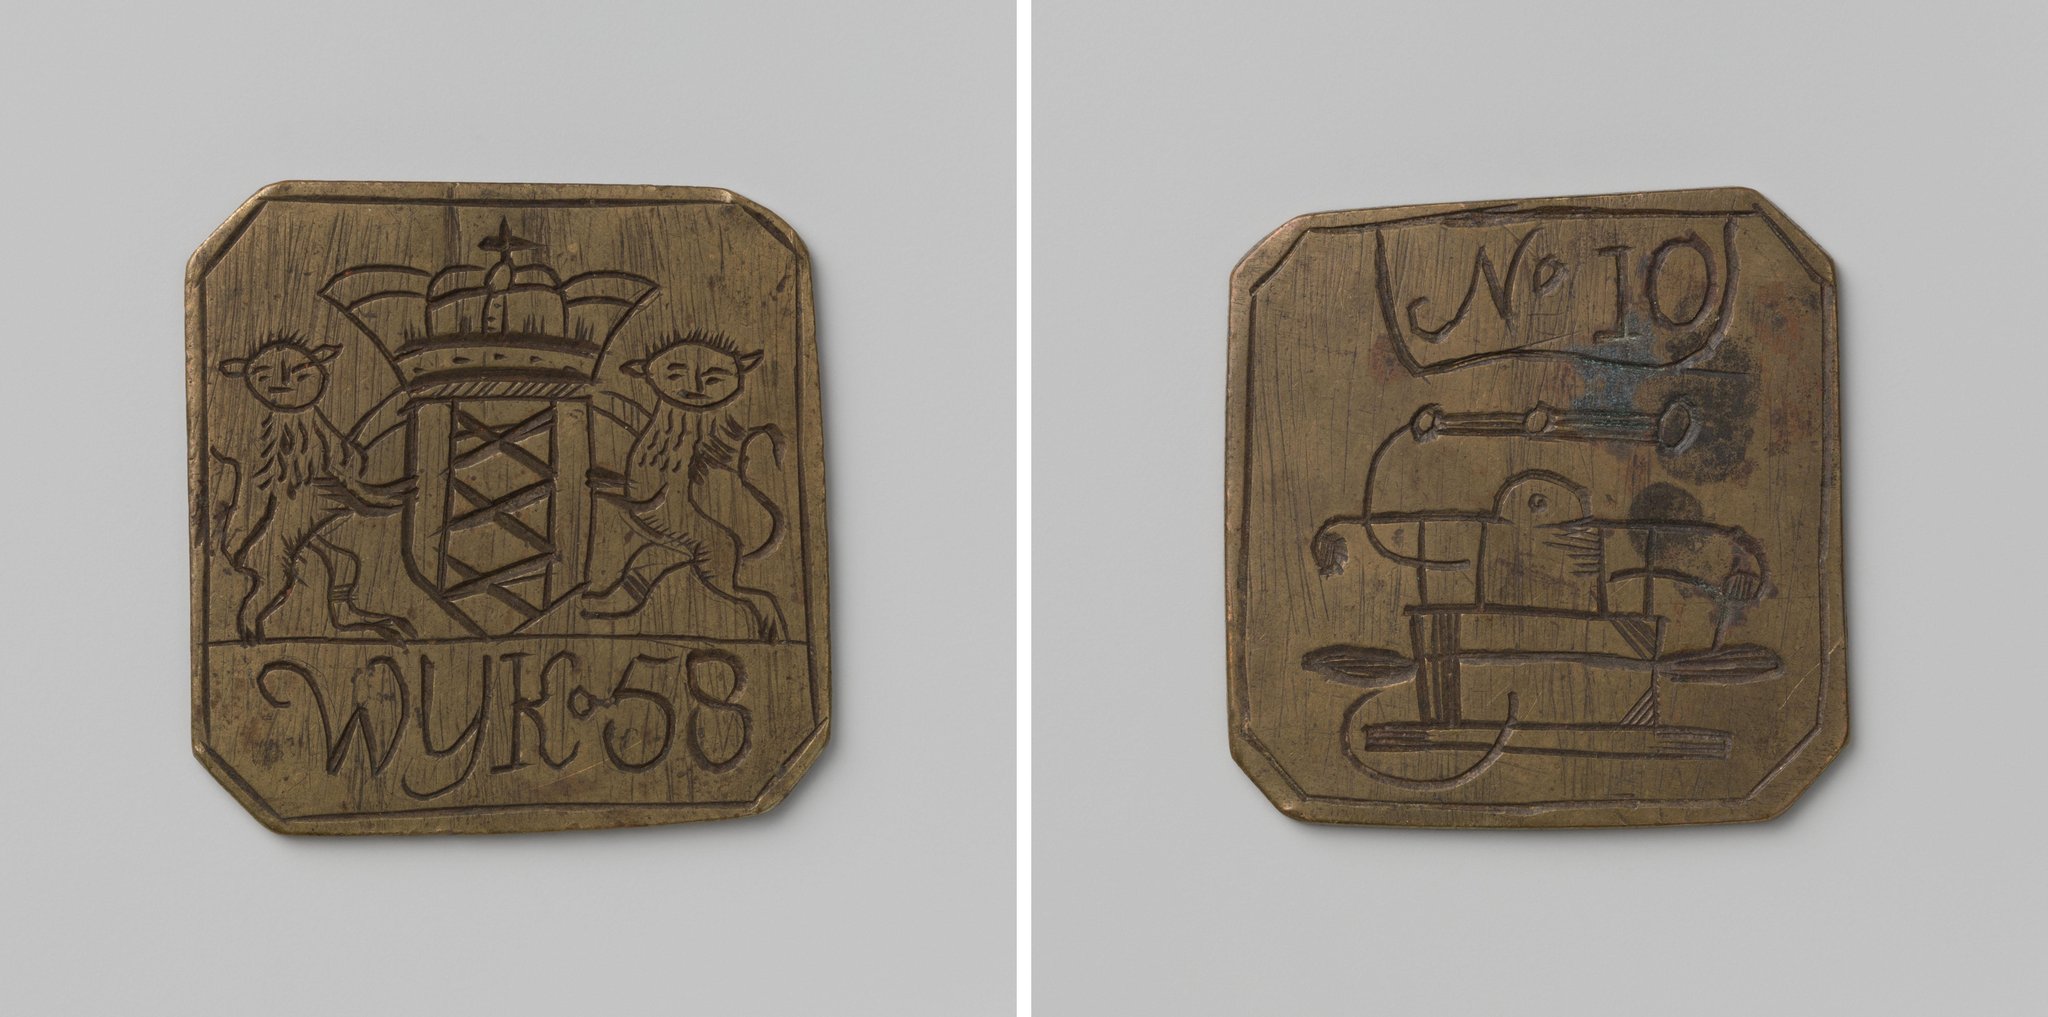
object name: medal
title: Amsterdam, brandspuitpenning van wijk 58 met no. 10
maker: Anonymous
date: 1680-1800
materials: brass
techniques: engraving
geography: amsterdam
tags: amsterdam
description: Messing vierkante penning met afgeschuinde hoeken. Voorzijde: gekroond wapenschild, geflankeerd door twee leeuwen; afsnede: opschrift: wijk 58. Keerzijde: brandspuit onder cartouche met opschrift no. 10.